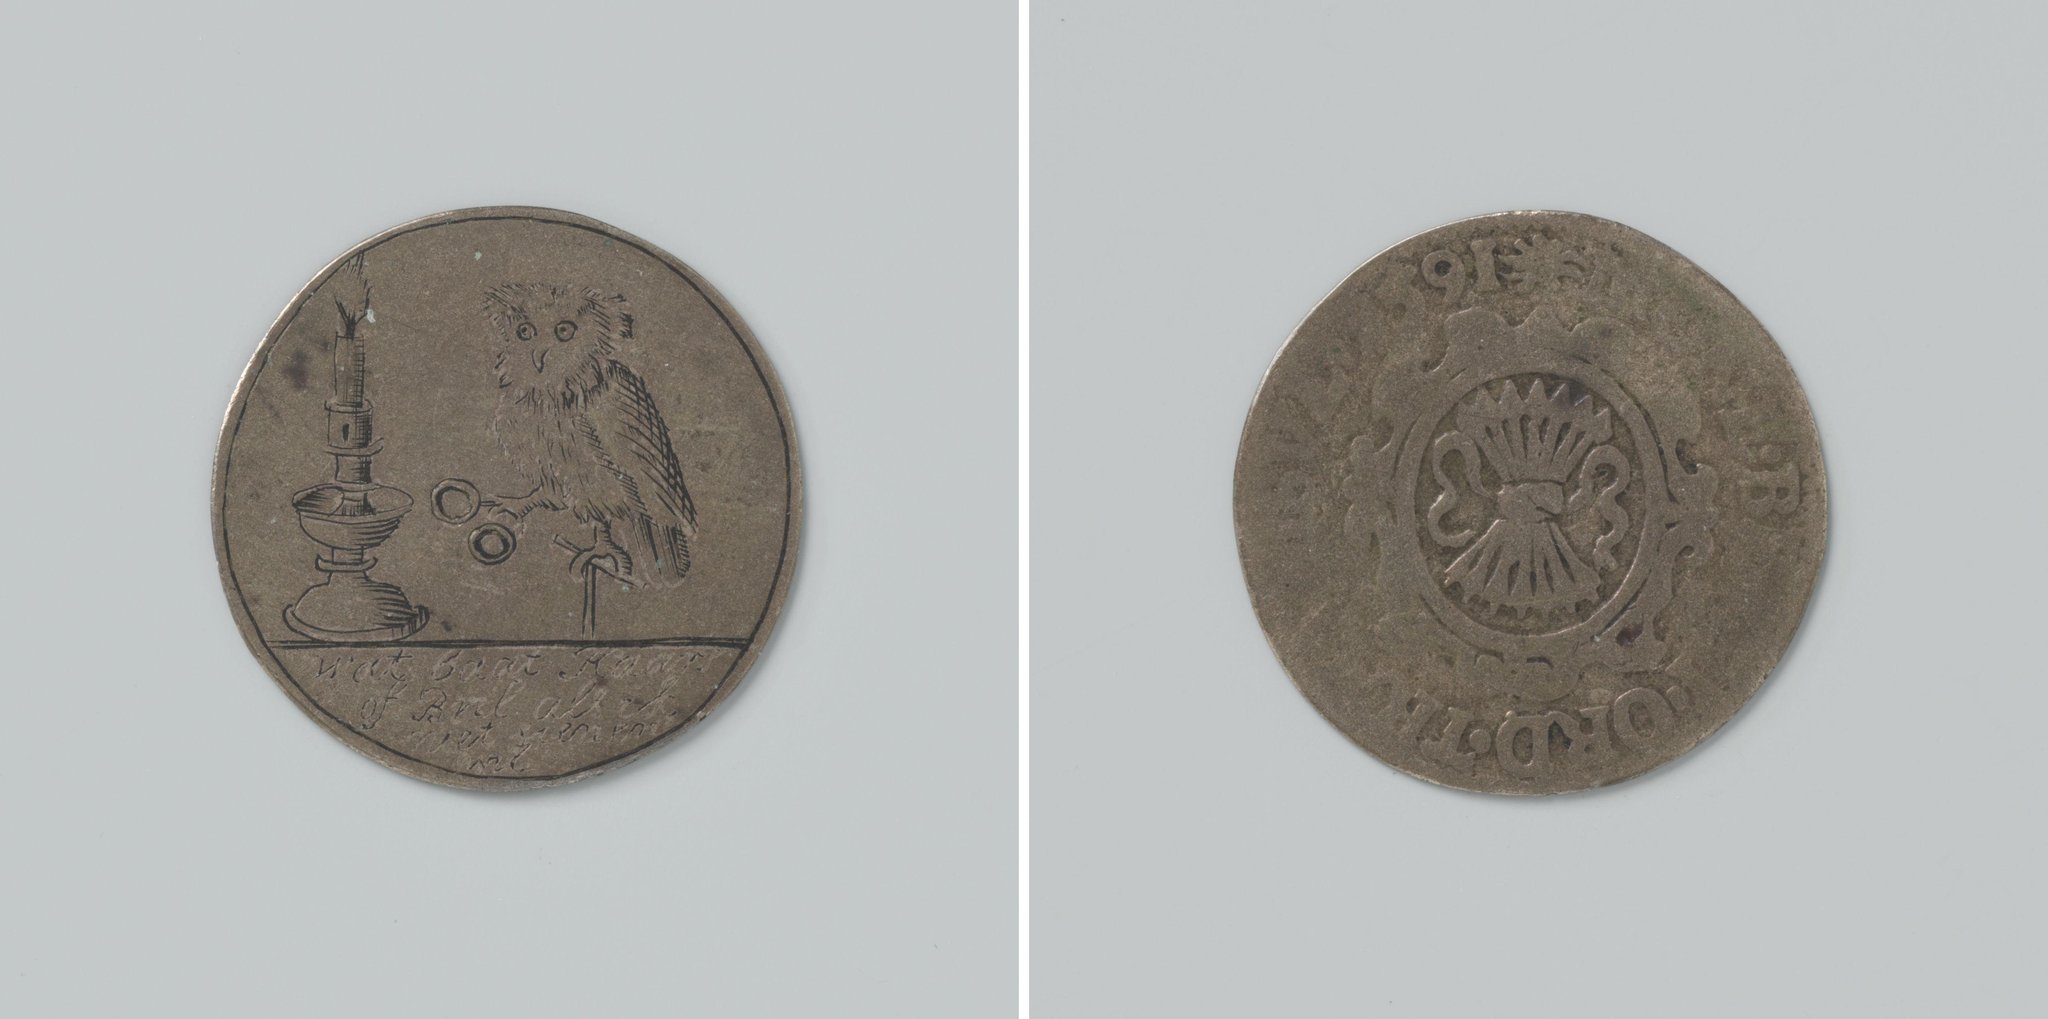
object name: medal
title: Conflict tussen Gomarus en Arminius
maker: Anonymous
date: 1591-1610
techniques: engraving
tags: remonstranten en contraremonstranten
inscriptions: : ‘wat baet Kaars / of Bril als ik / niet sien en / wil’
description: Naar een rekenpenning uit 1553 over het conflict tussen Calvijn en Servet, die tot de brandstapel werd veroordeeld